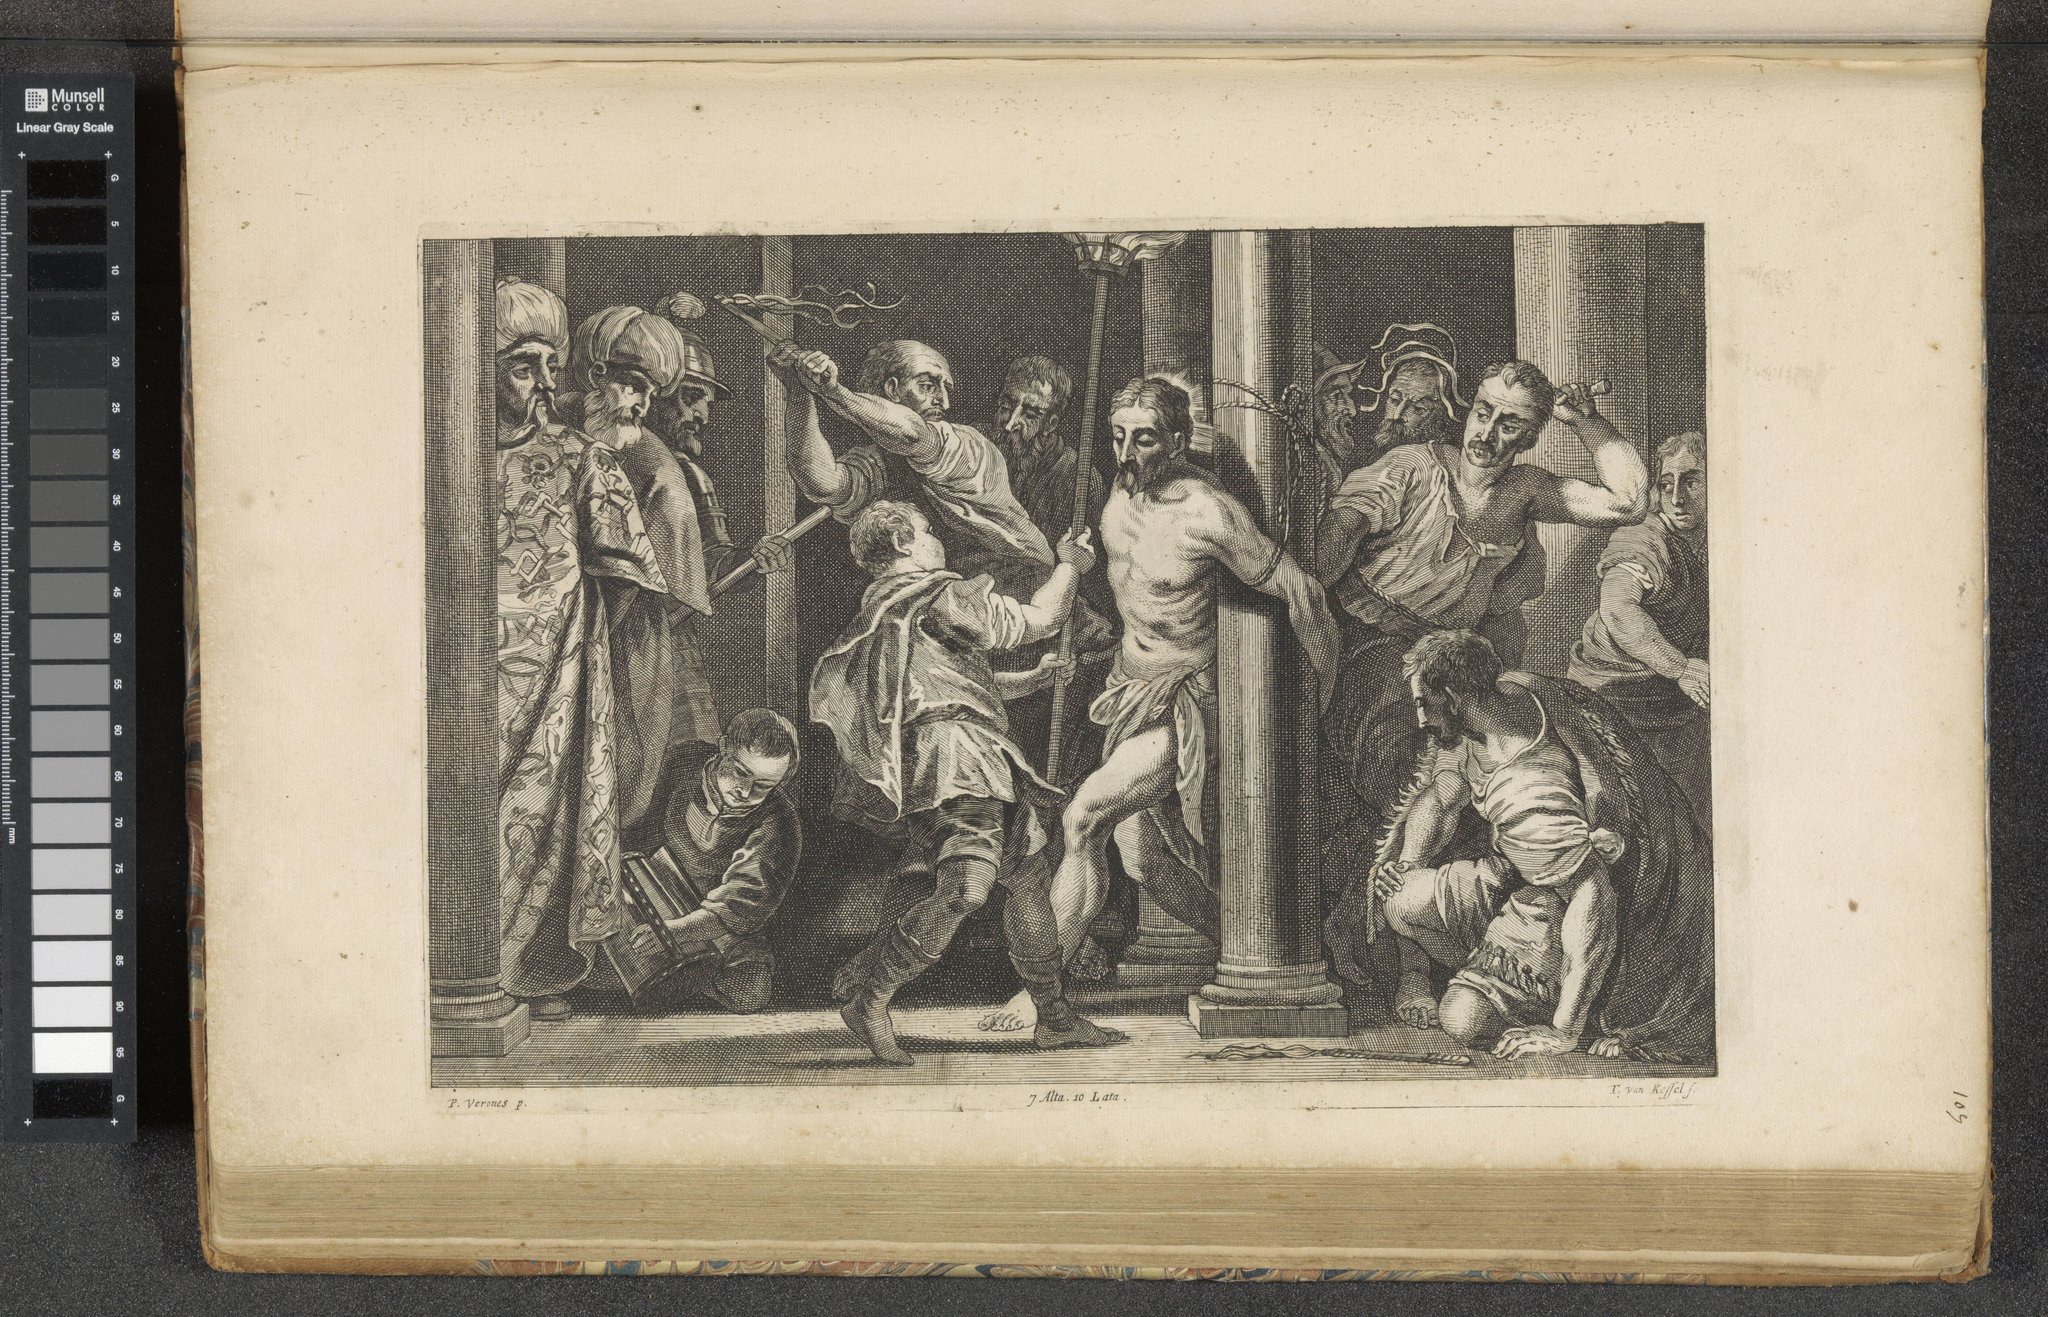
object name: album leaf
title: Geseling van Christus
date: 1660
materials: paper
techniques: engraving, etching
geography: southern netherlands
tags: flagellation by soldiers, christ usually tied to a column (matthew 27:26; mark 15:15; john 19:1)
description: David Teniers heeft waarschijnlijk van alle schilderijen uit de collectie van Leopold Willem van Oostenrijk een olieverfstudie op doek of paneel vervaardigd (zgn. pasticcio), die als voorbeeld voor de prentmakers diende. Het is niet altijd duidelijk of de pasticci door hem zijn gemaakt of door zijn atelier. Niet alle pasticci zijn overgeleverd.